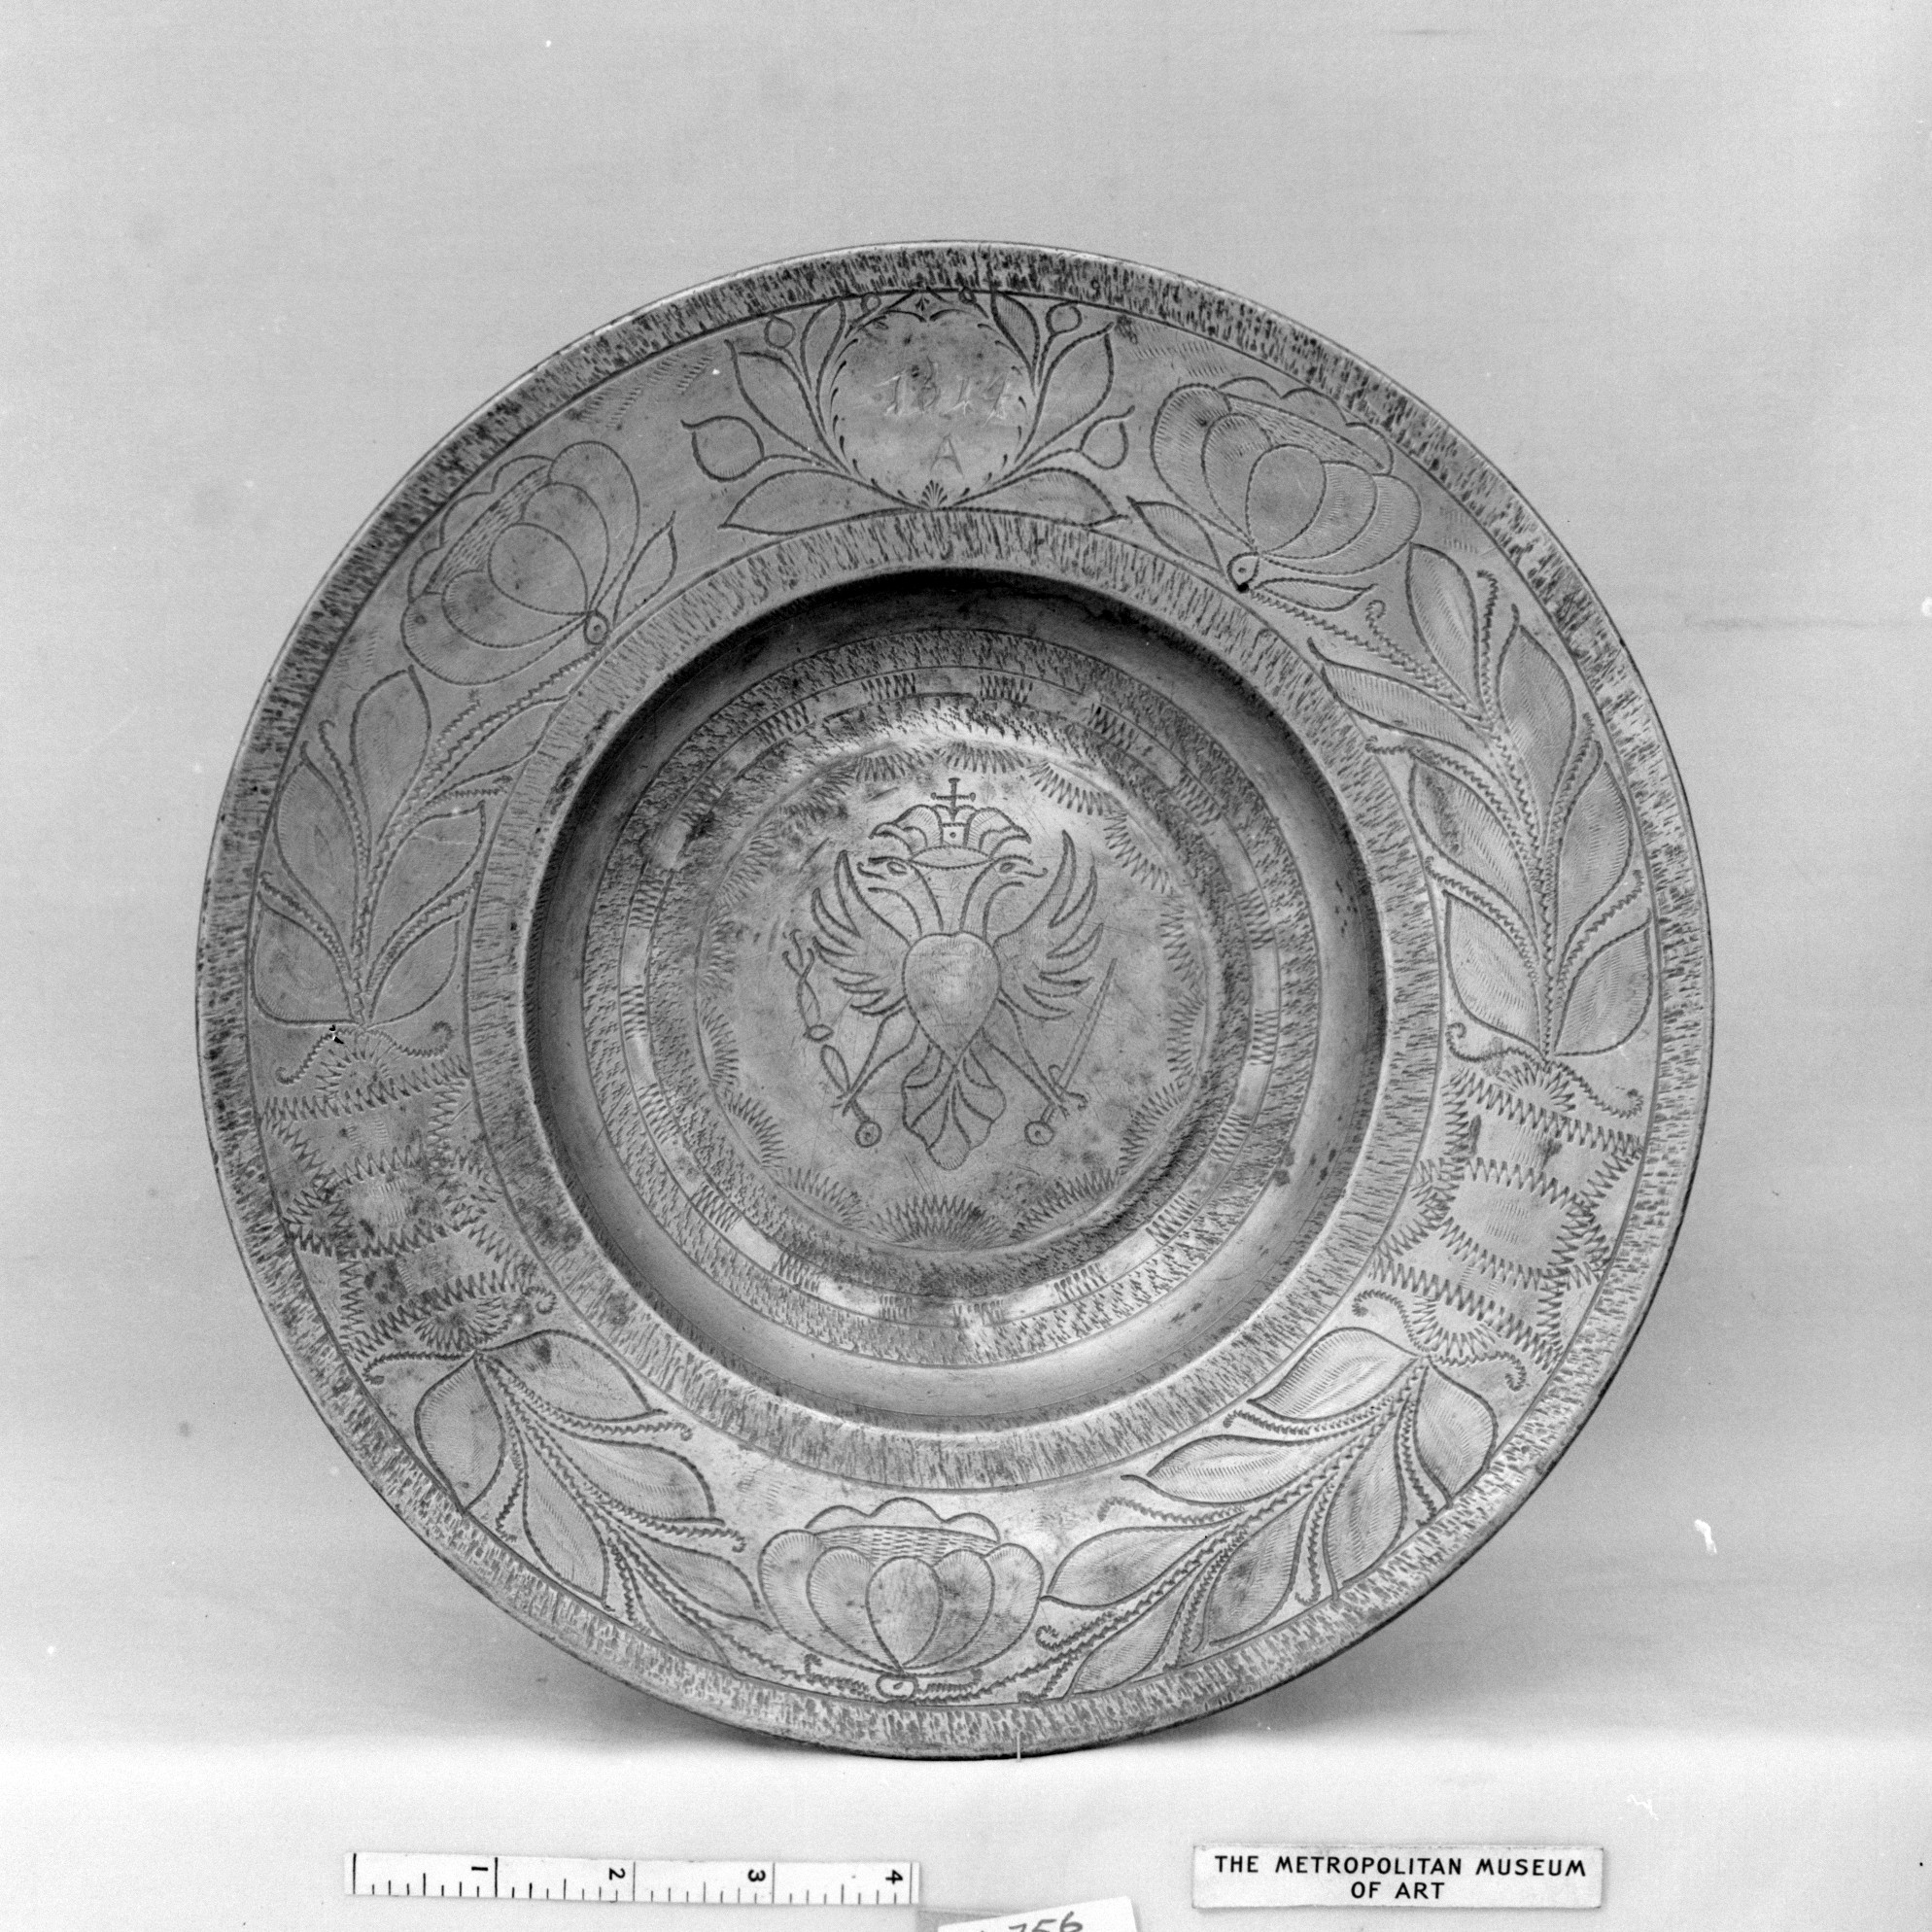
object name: plate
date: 1701-1800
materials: pewter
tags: flowers,coat of arms